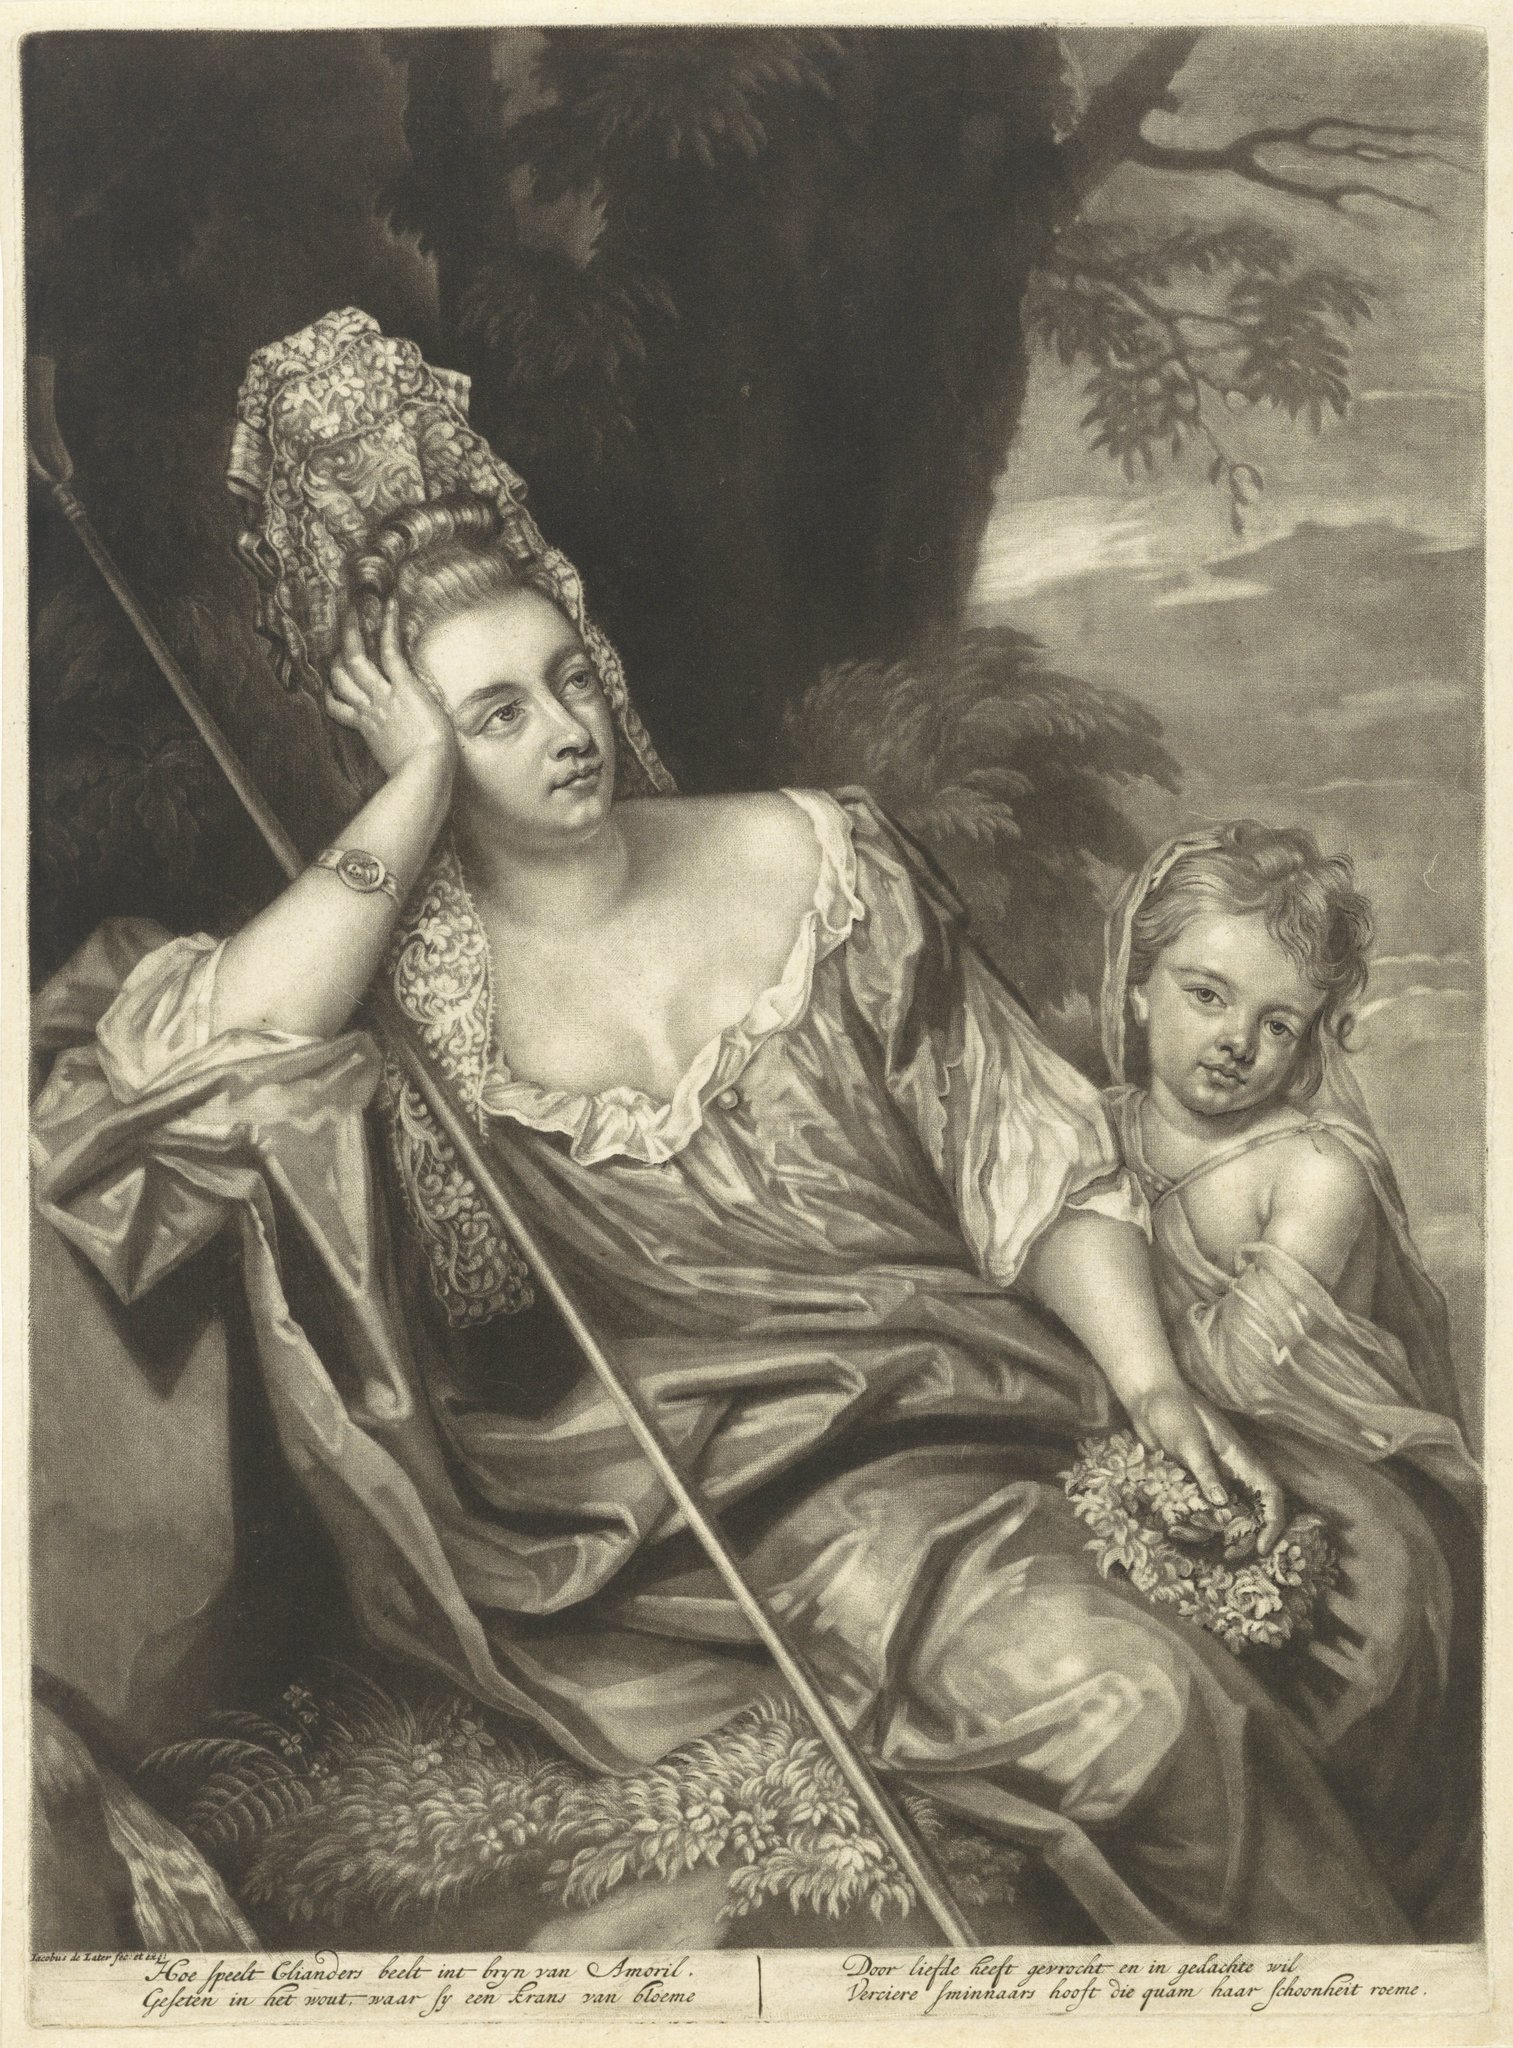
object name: print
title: Amaryllis als herderin met een kind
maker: jacob de later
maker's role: print maker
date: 1696-1709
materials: paper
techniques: engraving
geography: amsterdam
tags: cut flowers; nosegay, bunch of flowers, (scenes from) specific works of literature (with author, title)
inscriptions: collector's mark: Lugt 2228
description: Amaryllis zit onder een boom, naast haar staat een kind. In de hand heeft ze een bloemenkrans en om de pols een bandje waaraan een medaillon met een portret.